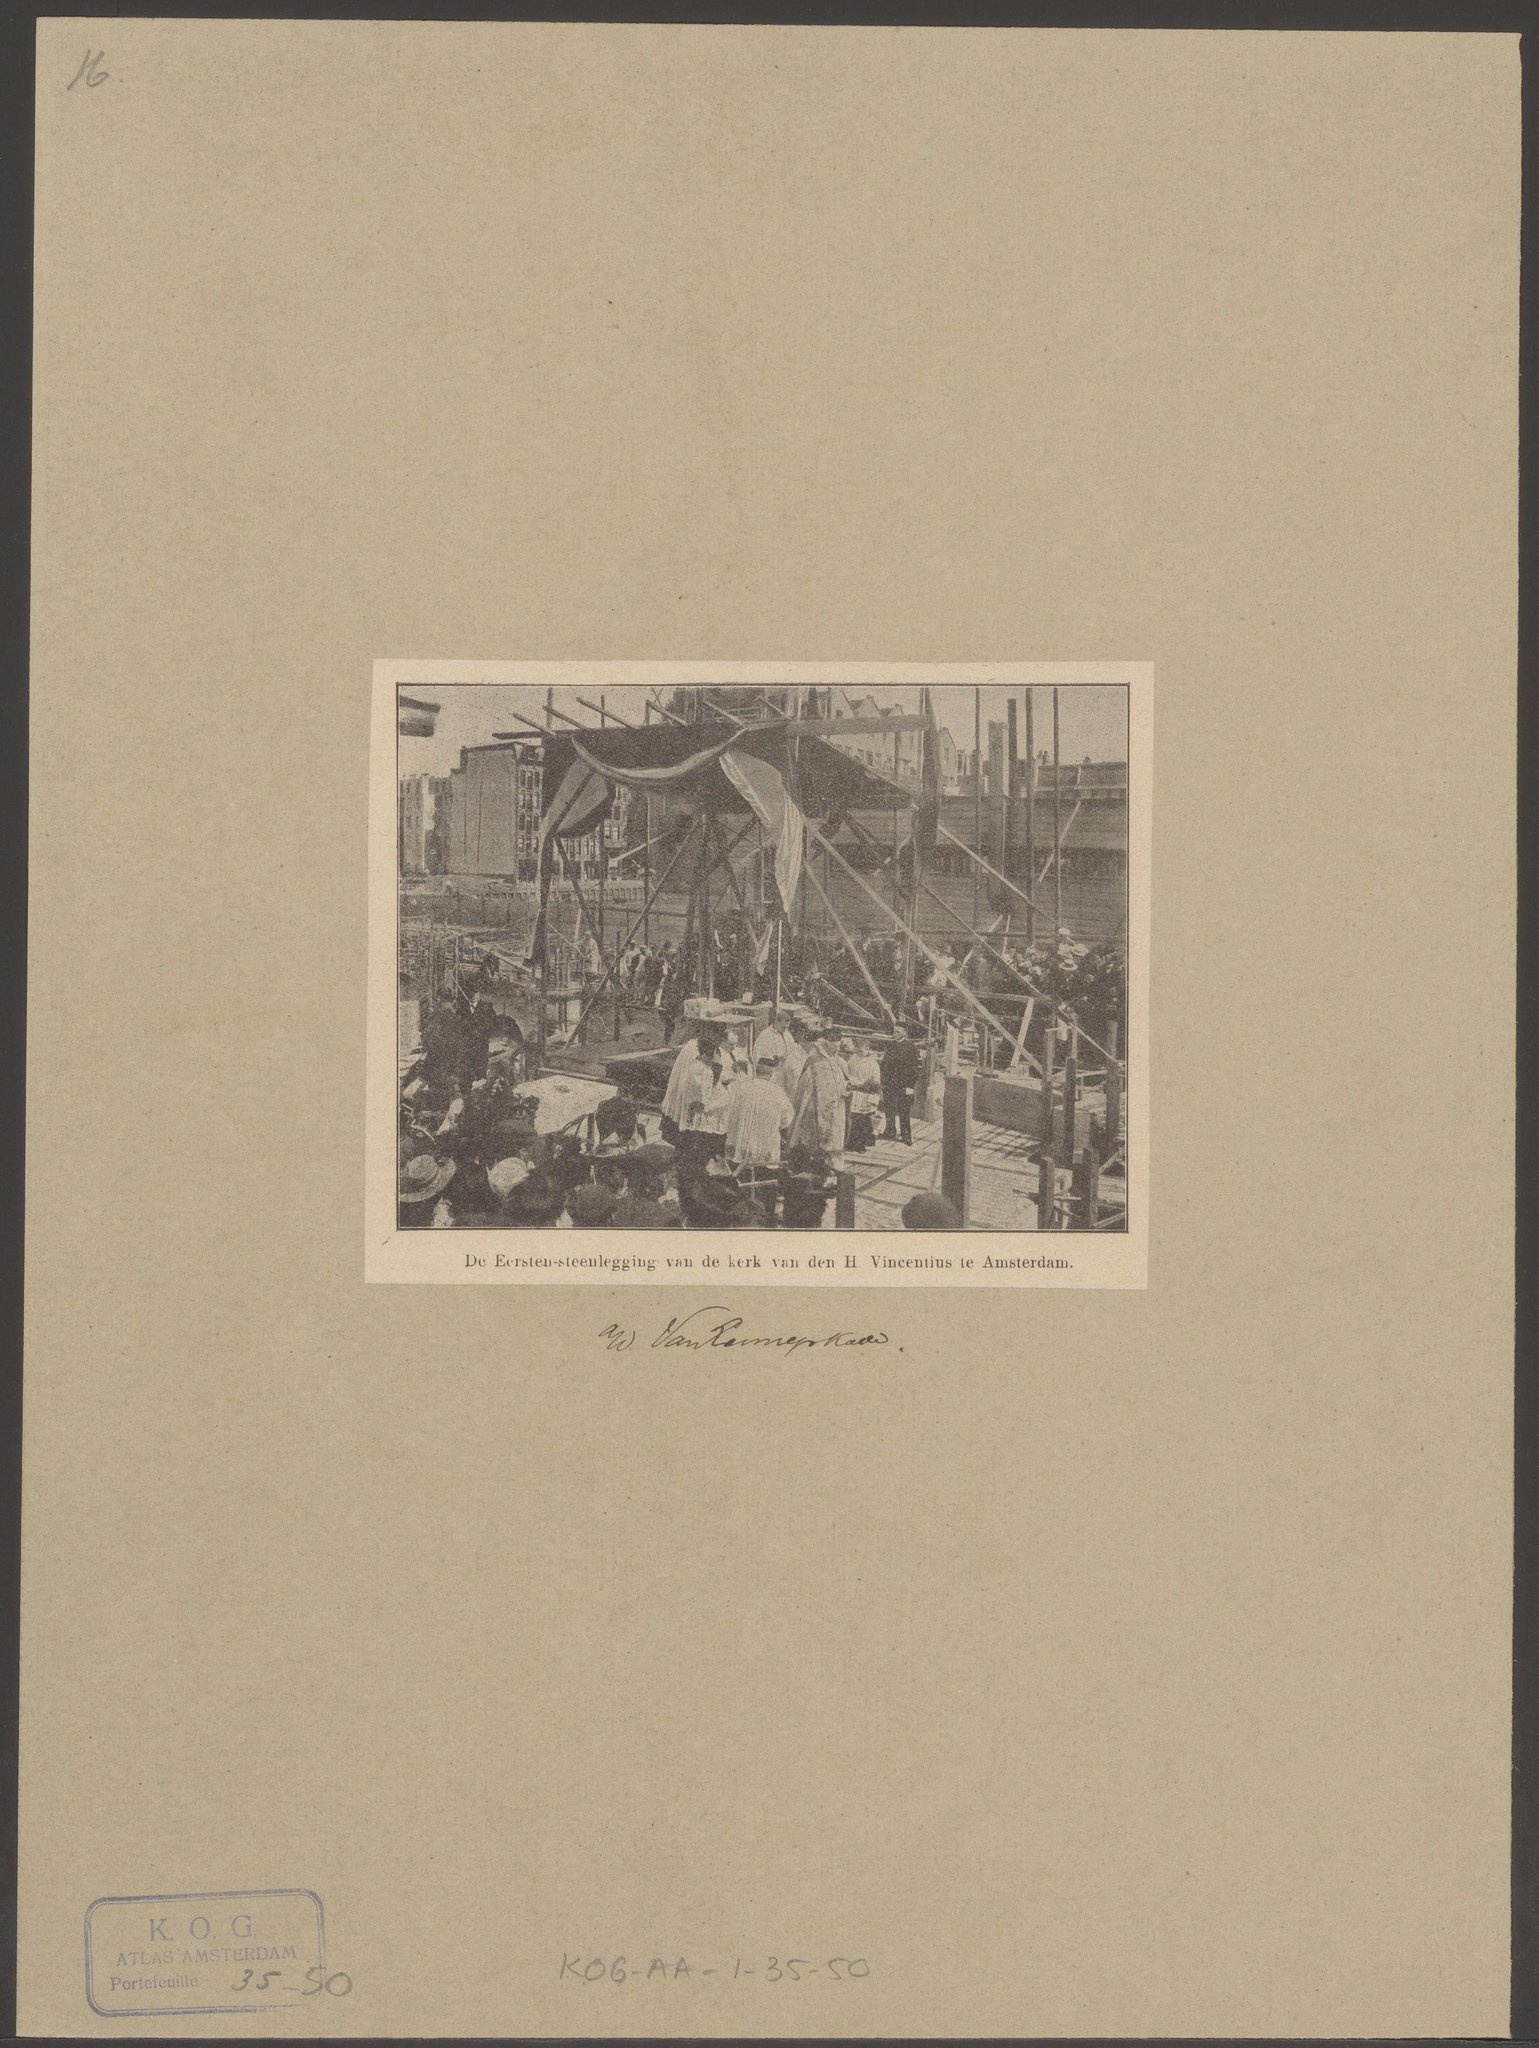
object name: photomechanical print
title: De Eersten-steenlegging van de kerk van den H. Vincentius te Amsterdam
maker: Anonymous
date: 1900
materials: paper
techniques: letterpress printing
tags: roman catholic church, ceremonial laying of the foundations, laying the first stone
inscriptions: collector's mark: ‘35-50’ Lugt 1641b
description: Geknipt uit een onbekende publicatie. Onderwerpsrubriek binnen de Atlas Amsterdam: R.K. Gemeenten: Sint Nicolaaskerk t/m Willibrordus (Rustenburgerstraat).